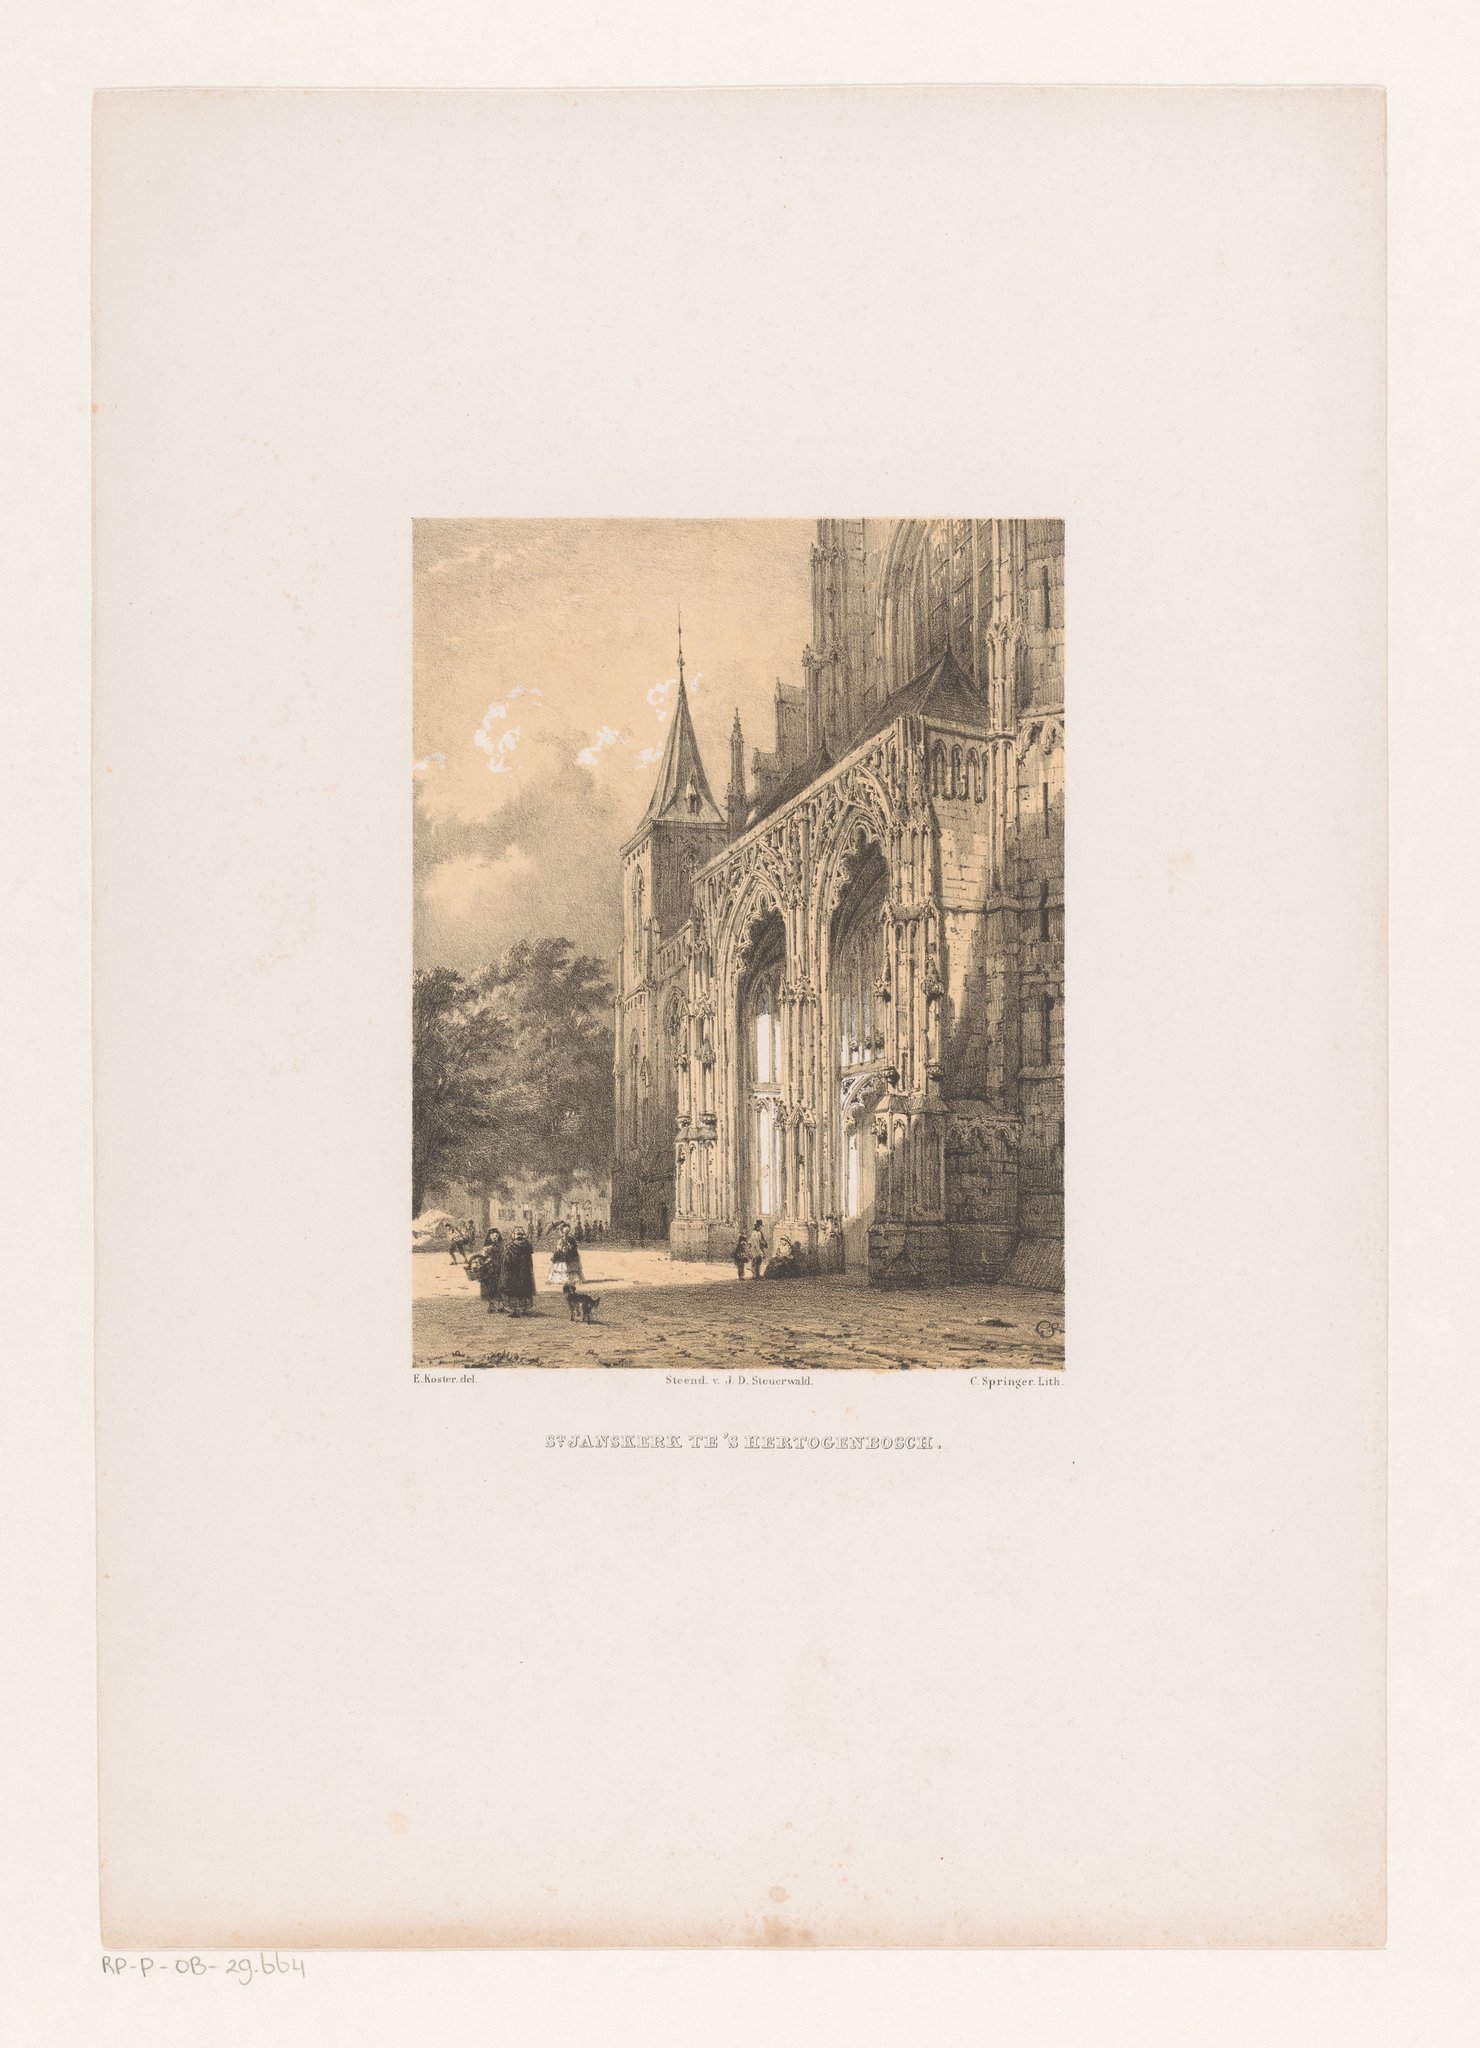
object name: print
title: St. Jankerk te 's Hertogenbosch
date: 1827-1863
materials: paper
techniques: tone lithography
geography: the hague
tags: church (exterior)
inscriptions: collector's mark: Lugt 2228